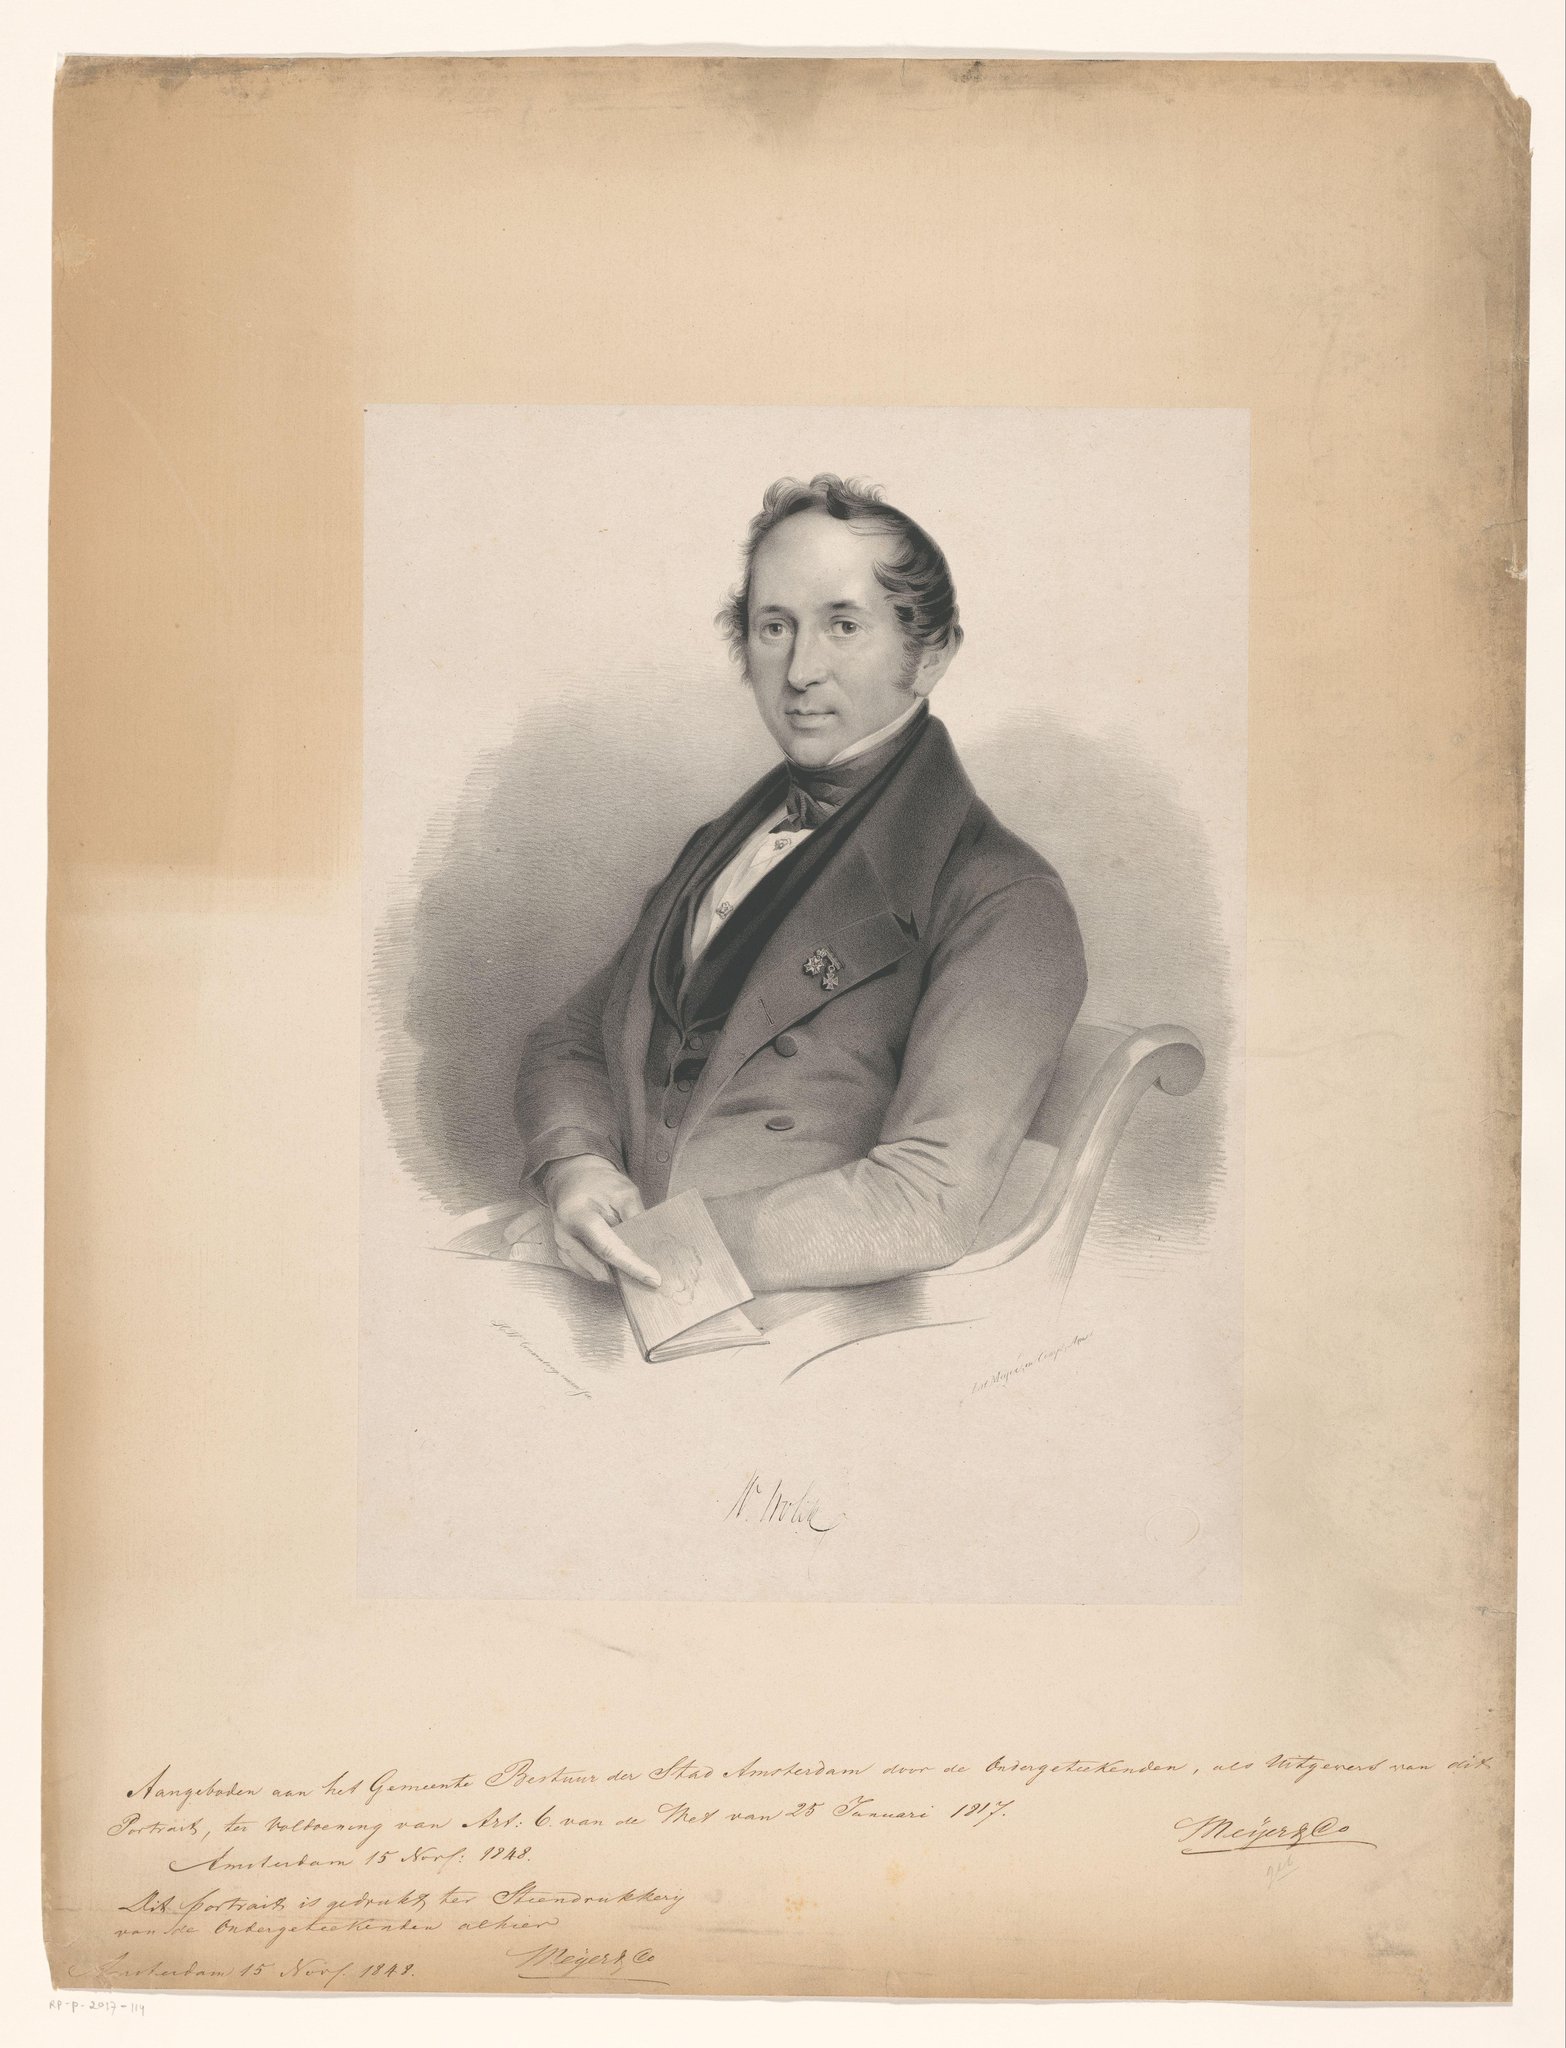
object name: print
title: Portret van Willem Vrolik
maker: henricus wilhelmus couwenberg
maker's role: draughtsman, print maker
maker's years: 1814-1845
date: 1848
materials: paper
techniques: lithograph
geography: amsterdam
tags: amsterdam, historical persons (+ (full) bust portrait)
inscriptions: : ‘Aangeboden aan het Gemeente Bestuur der stad Amsterdam door de ondergeteekenden, als uitgevers van dit / portret, ter voldoening van Art: 6 van de Wet van 25 Januari1817 / Amsterdam 15 Nov. 1848 Mijer&Co’, : ‘Dit portrait is gedrukt ter steendrukkerij / van de ondergeteekenden alhier / Amsterdam 15 nov 1848 Meijer&Co.’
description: Onder het portret de signatuur van de geportretteerde.